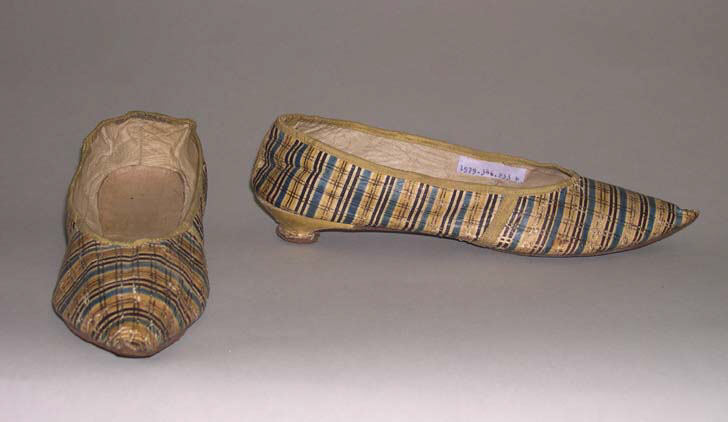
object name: slipper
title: Slippers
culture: british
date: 1790-1799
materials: leather, silk